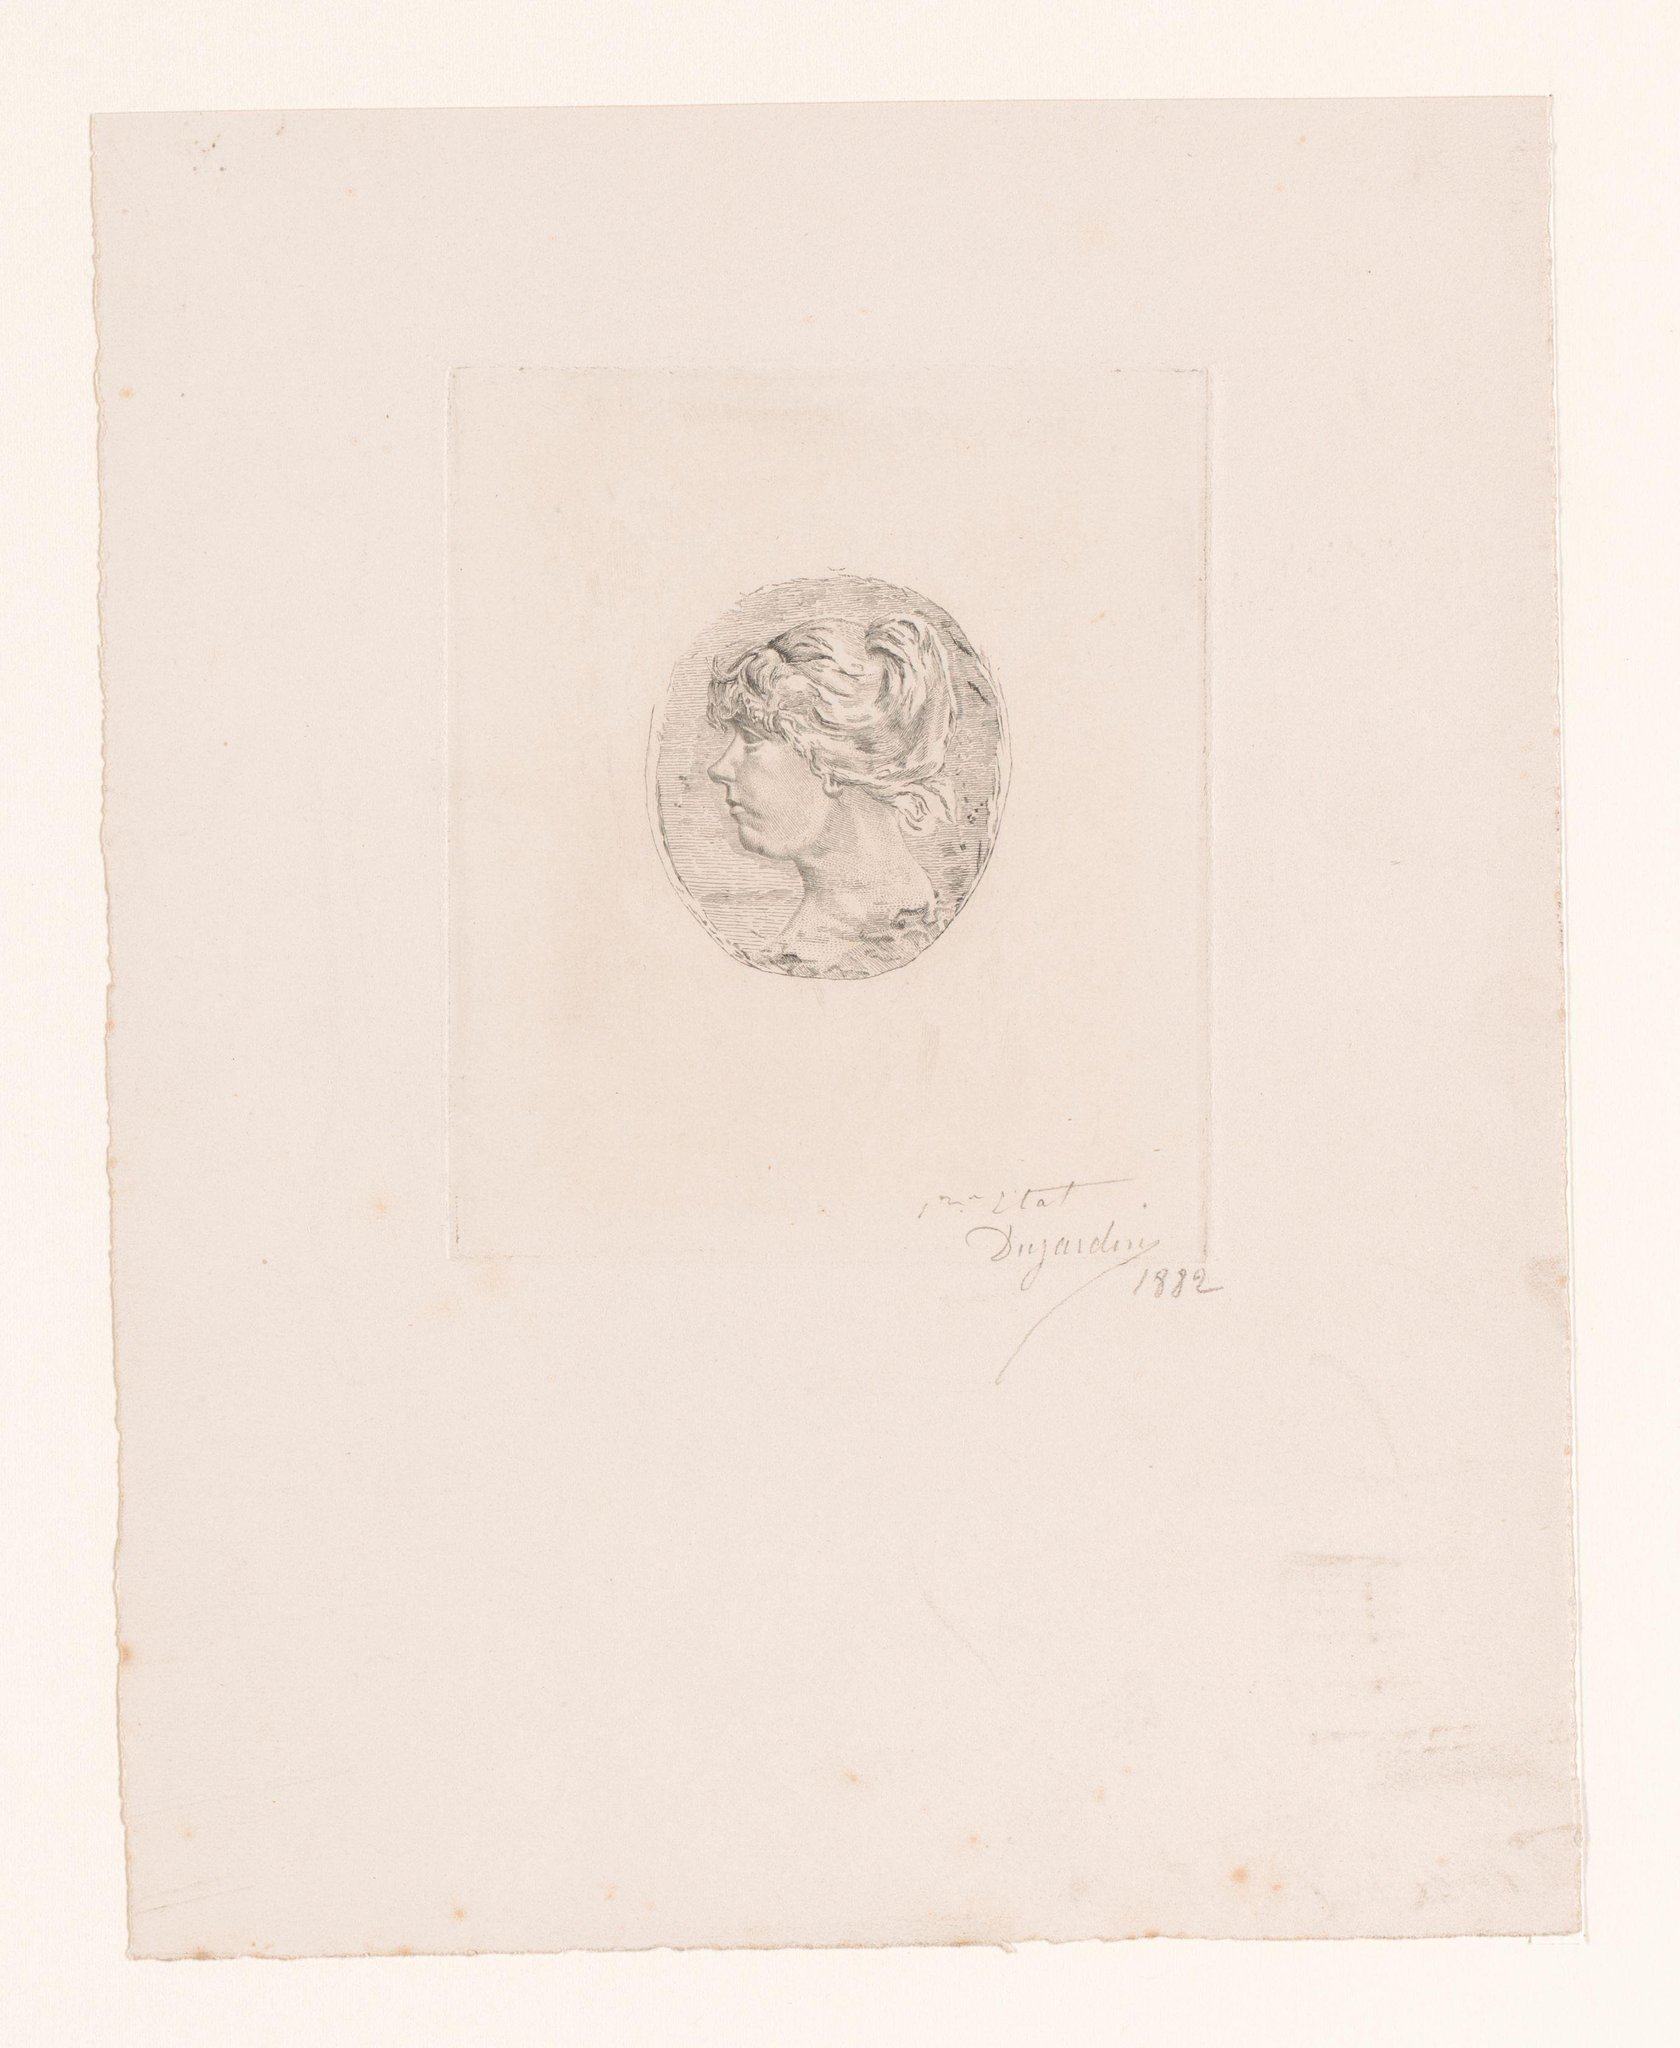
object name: print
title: Medaillon met onbekend vrouwenportret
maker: joseph dujardin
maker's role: print maker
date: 1882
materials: paper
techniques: etching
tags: adult woman, ornament ~ medallion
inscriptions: inscription: ‘1m Etat’, collector's mark: Lugt 2228